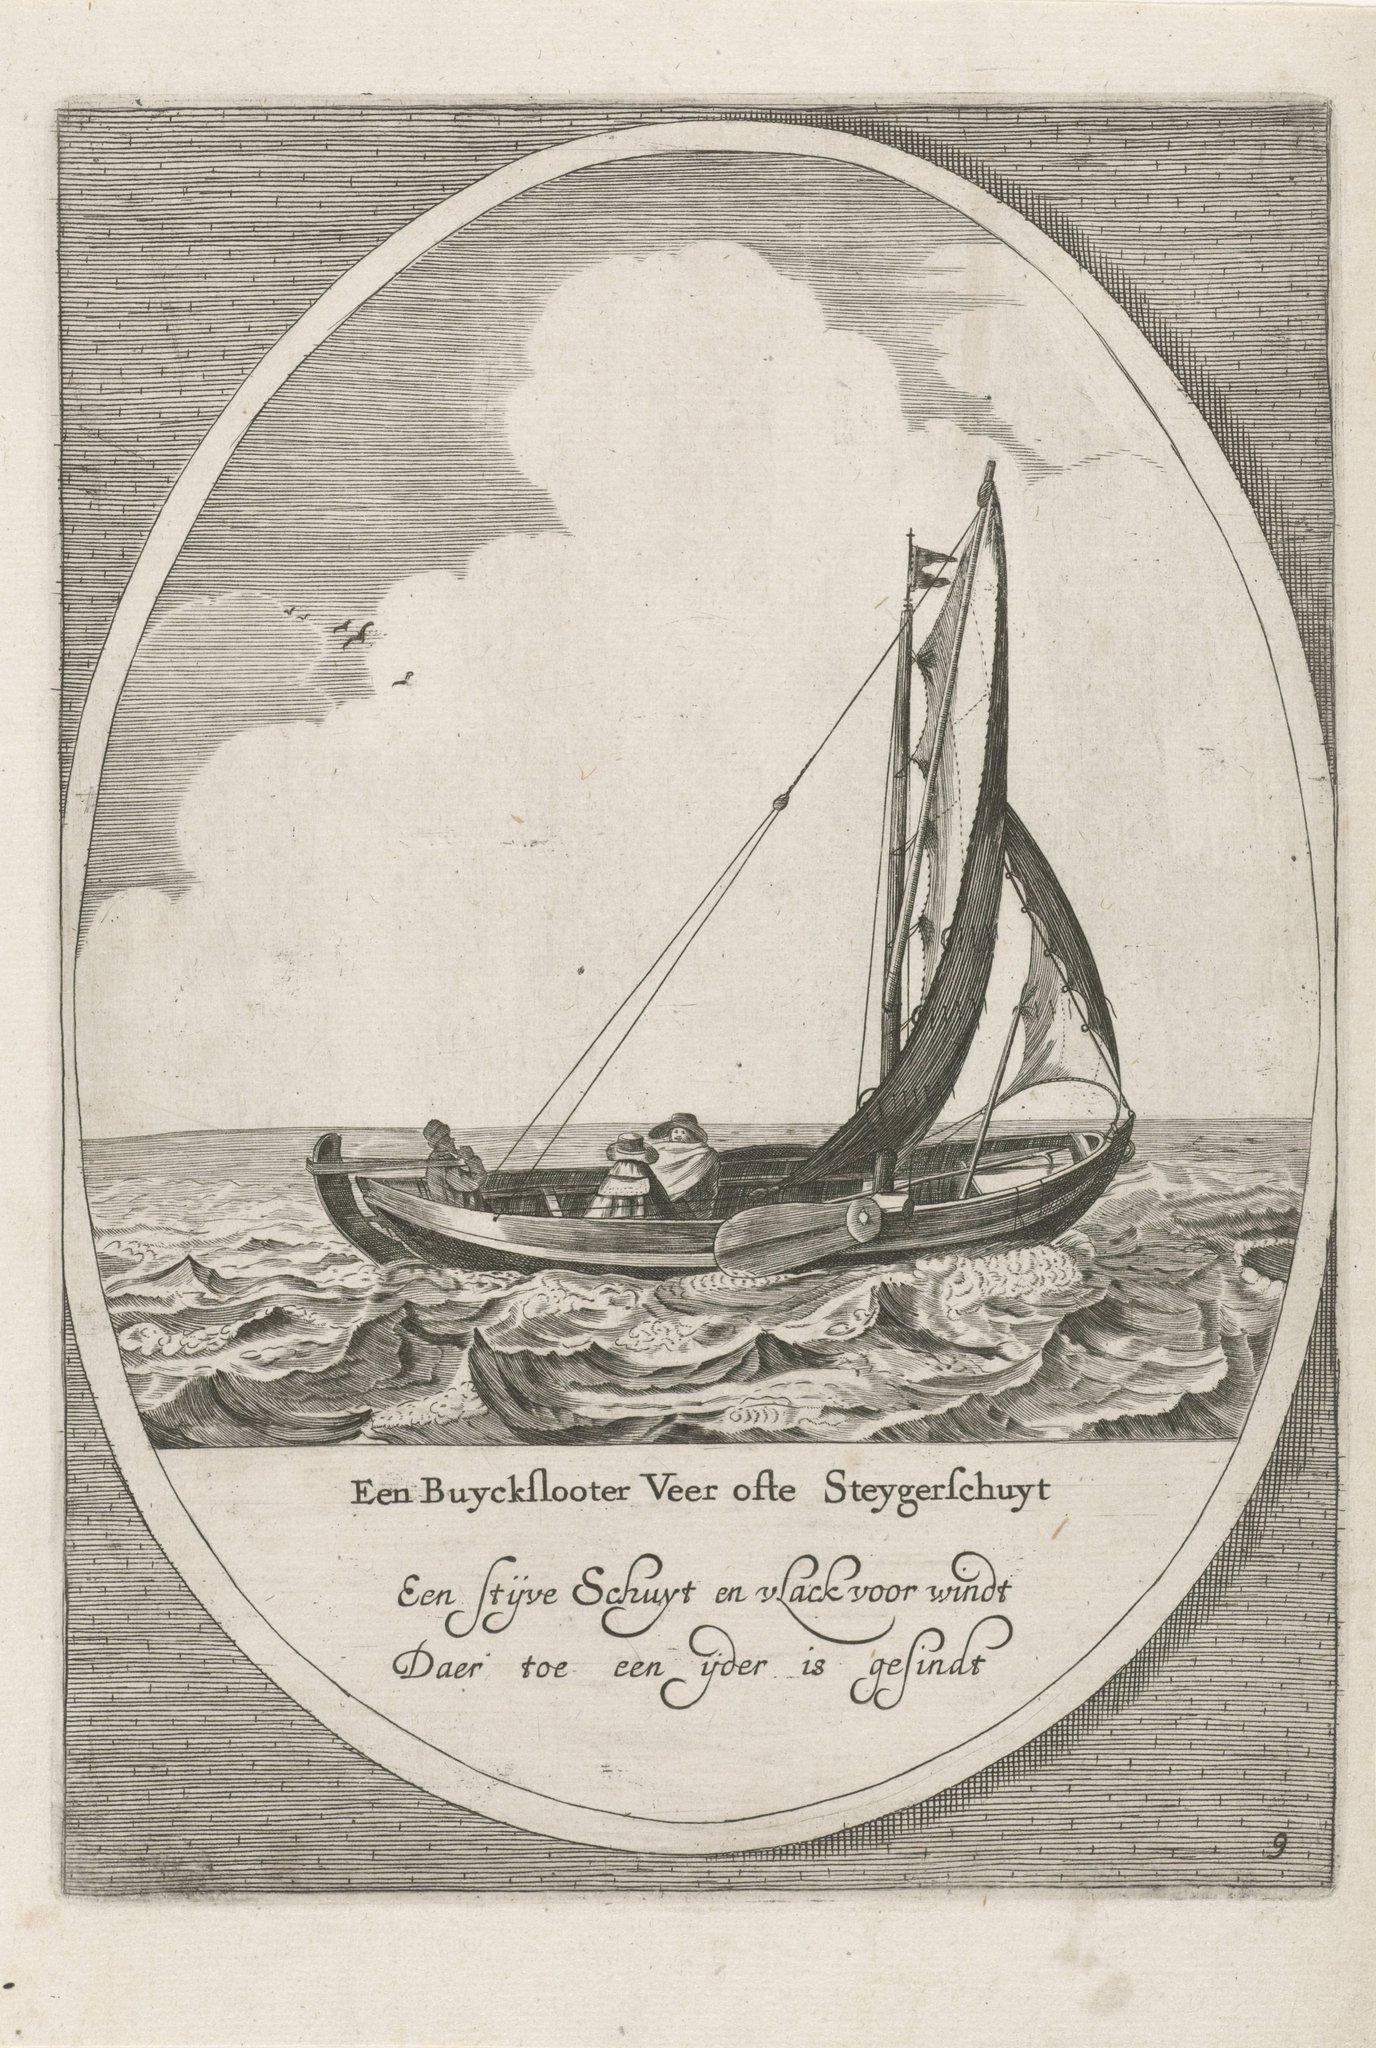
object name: print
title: Een Buyckslooter Veer ofte Steygerschuyt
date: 1642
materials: paper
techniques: engraving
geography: northern netherlands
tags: sailing-ship, sailing-boat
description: Een Buiksloterveer of steigerschuit, naar rechts, 1642. Met tweeregelig Nederlands vers. Blad nr. 9 in een serie van tien verschillende Hollandse typen binnenvaartschepen.